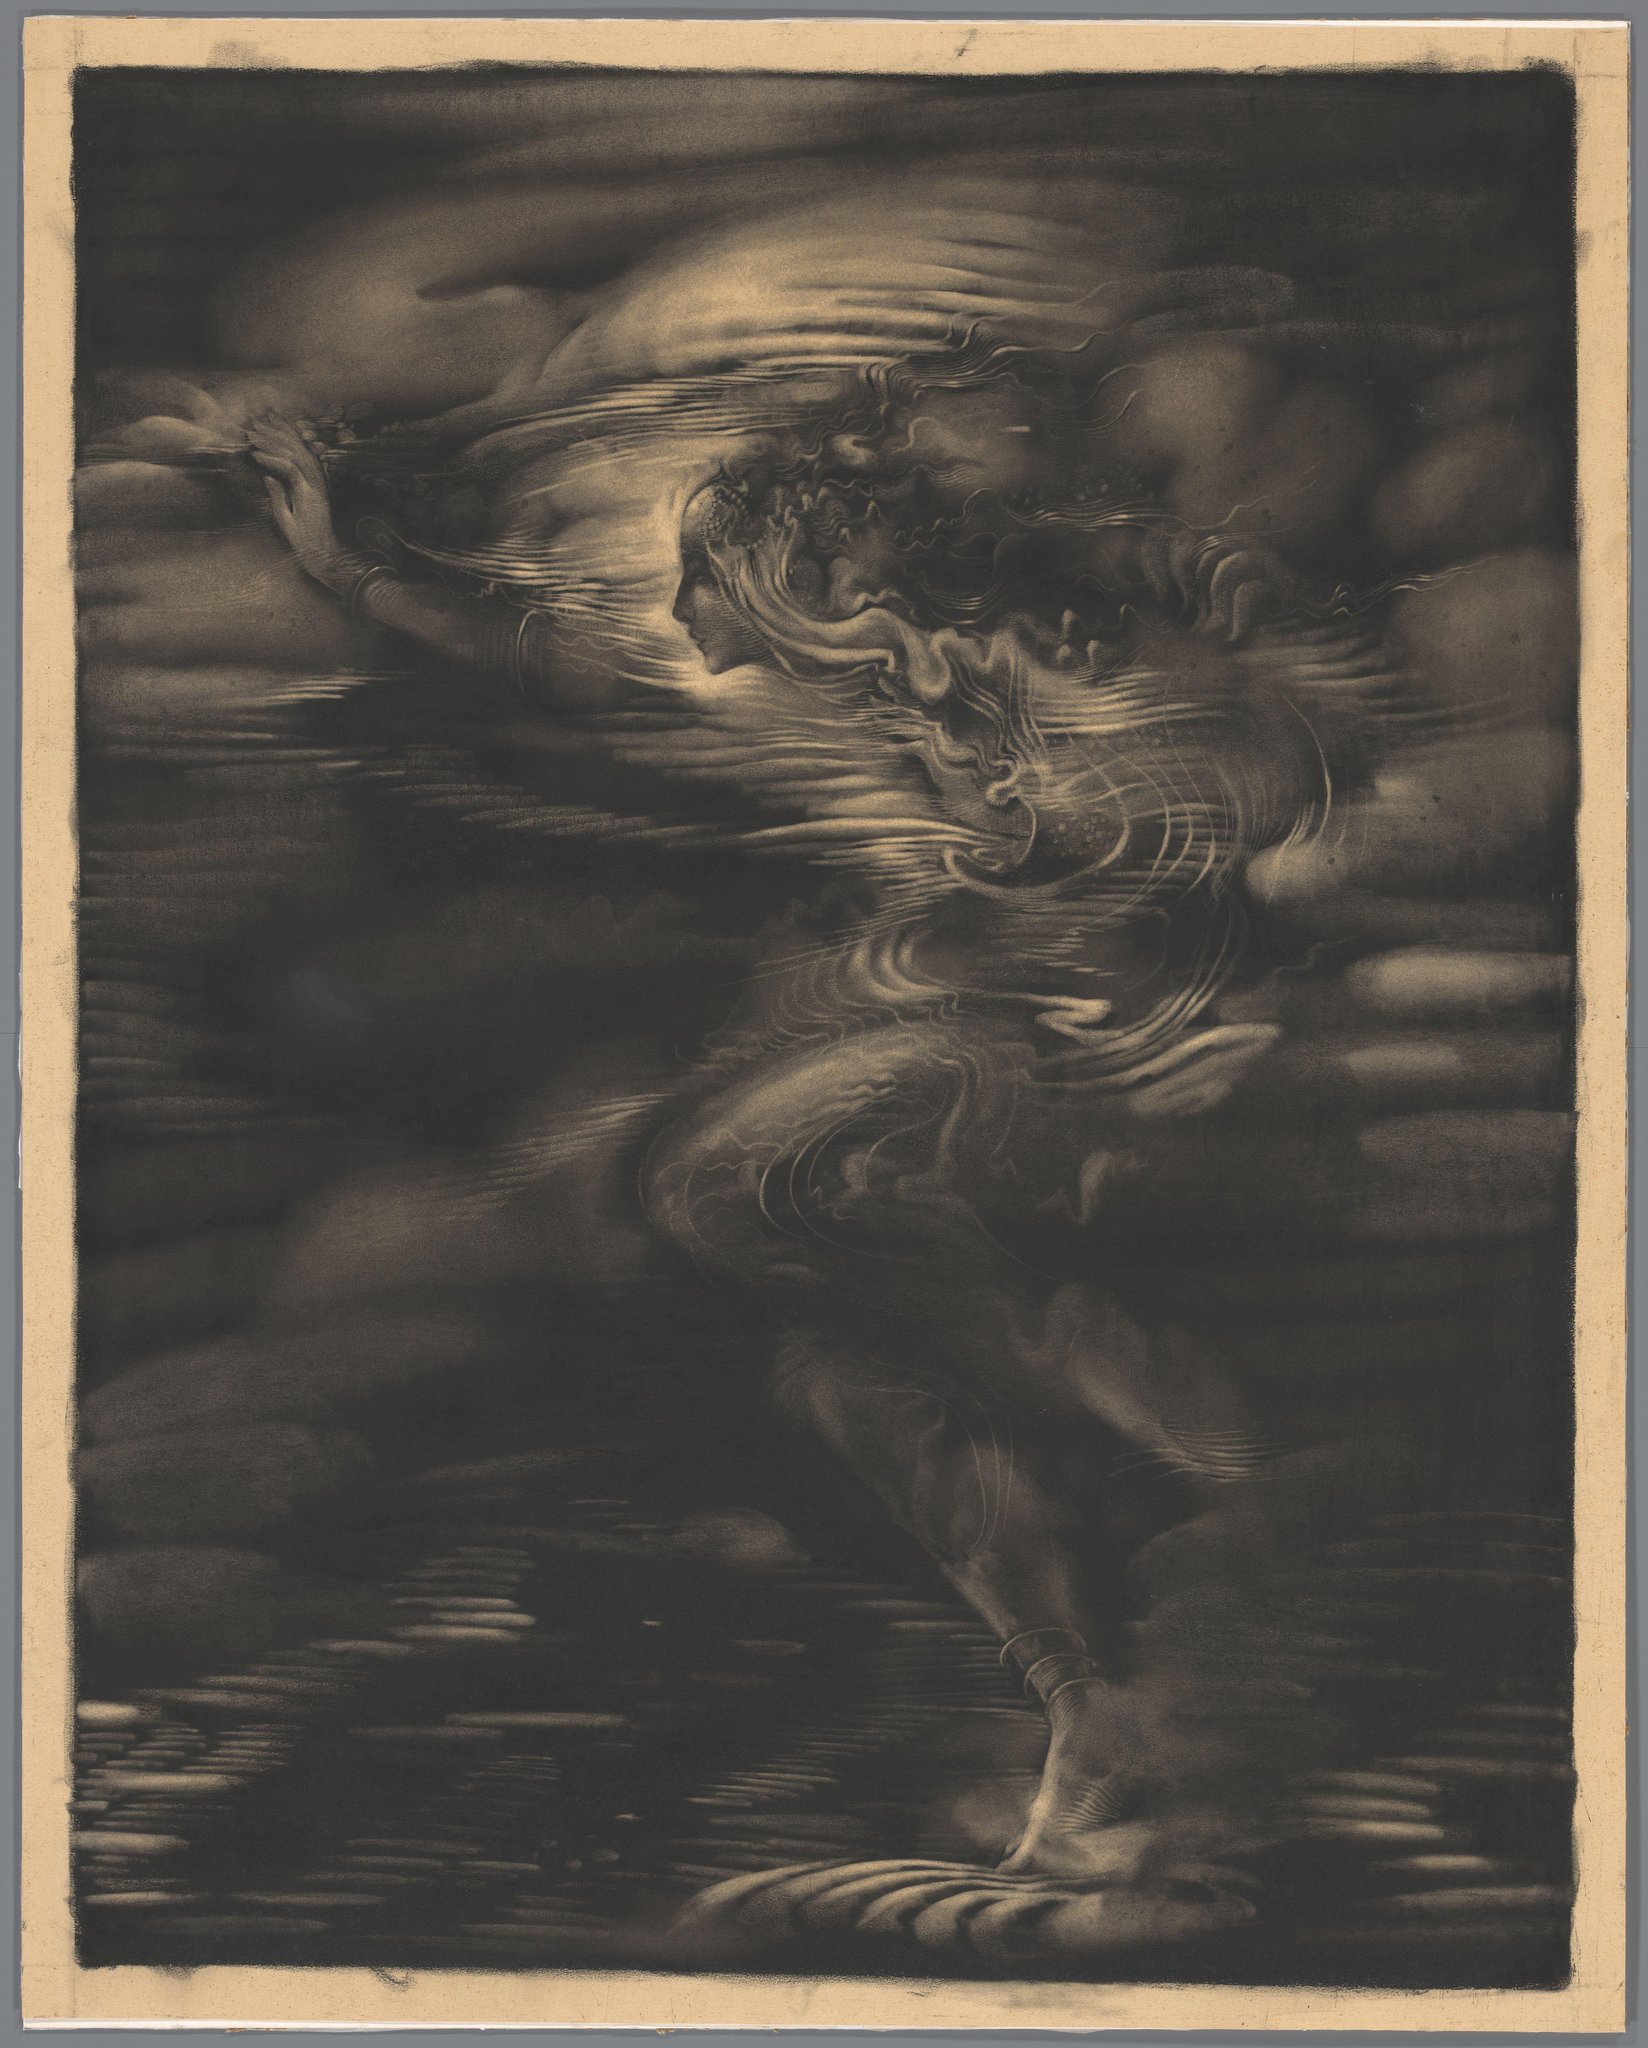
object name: drawing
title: Salome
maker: frans stamkart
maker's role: print maker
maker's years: 1874-1947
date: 1910-1915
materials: cardboard, chalk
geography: netherlands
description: Because of its biblical subject matter, this drawing by Frans Stamkart can be characterised as Symbolist art. However, the characterisation applies less to the technique, for which Stamkart developed an unorthodox approach of erasing certain passages in chalk. As a result, a soft light seems to break through behind the figure, giving shimmering edges to the swirling clouds, gown and veils.